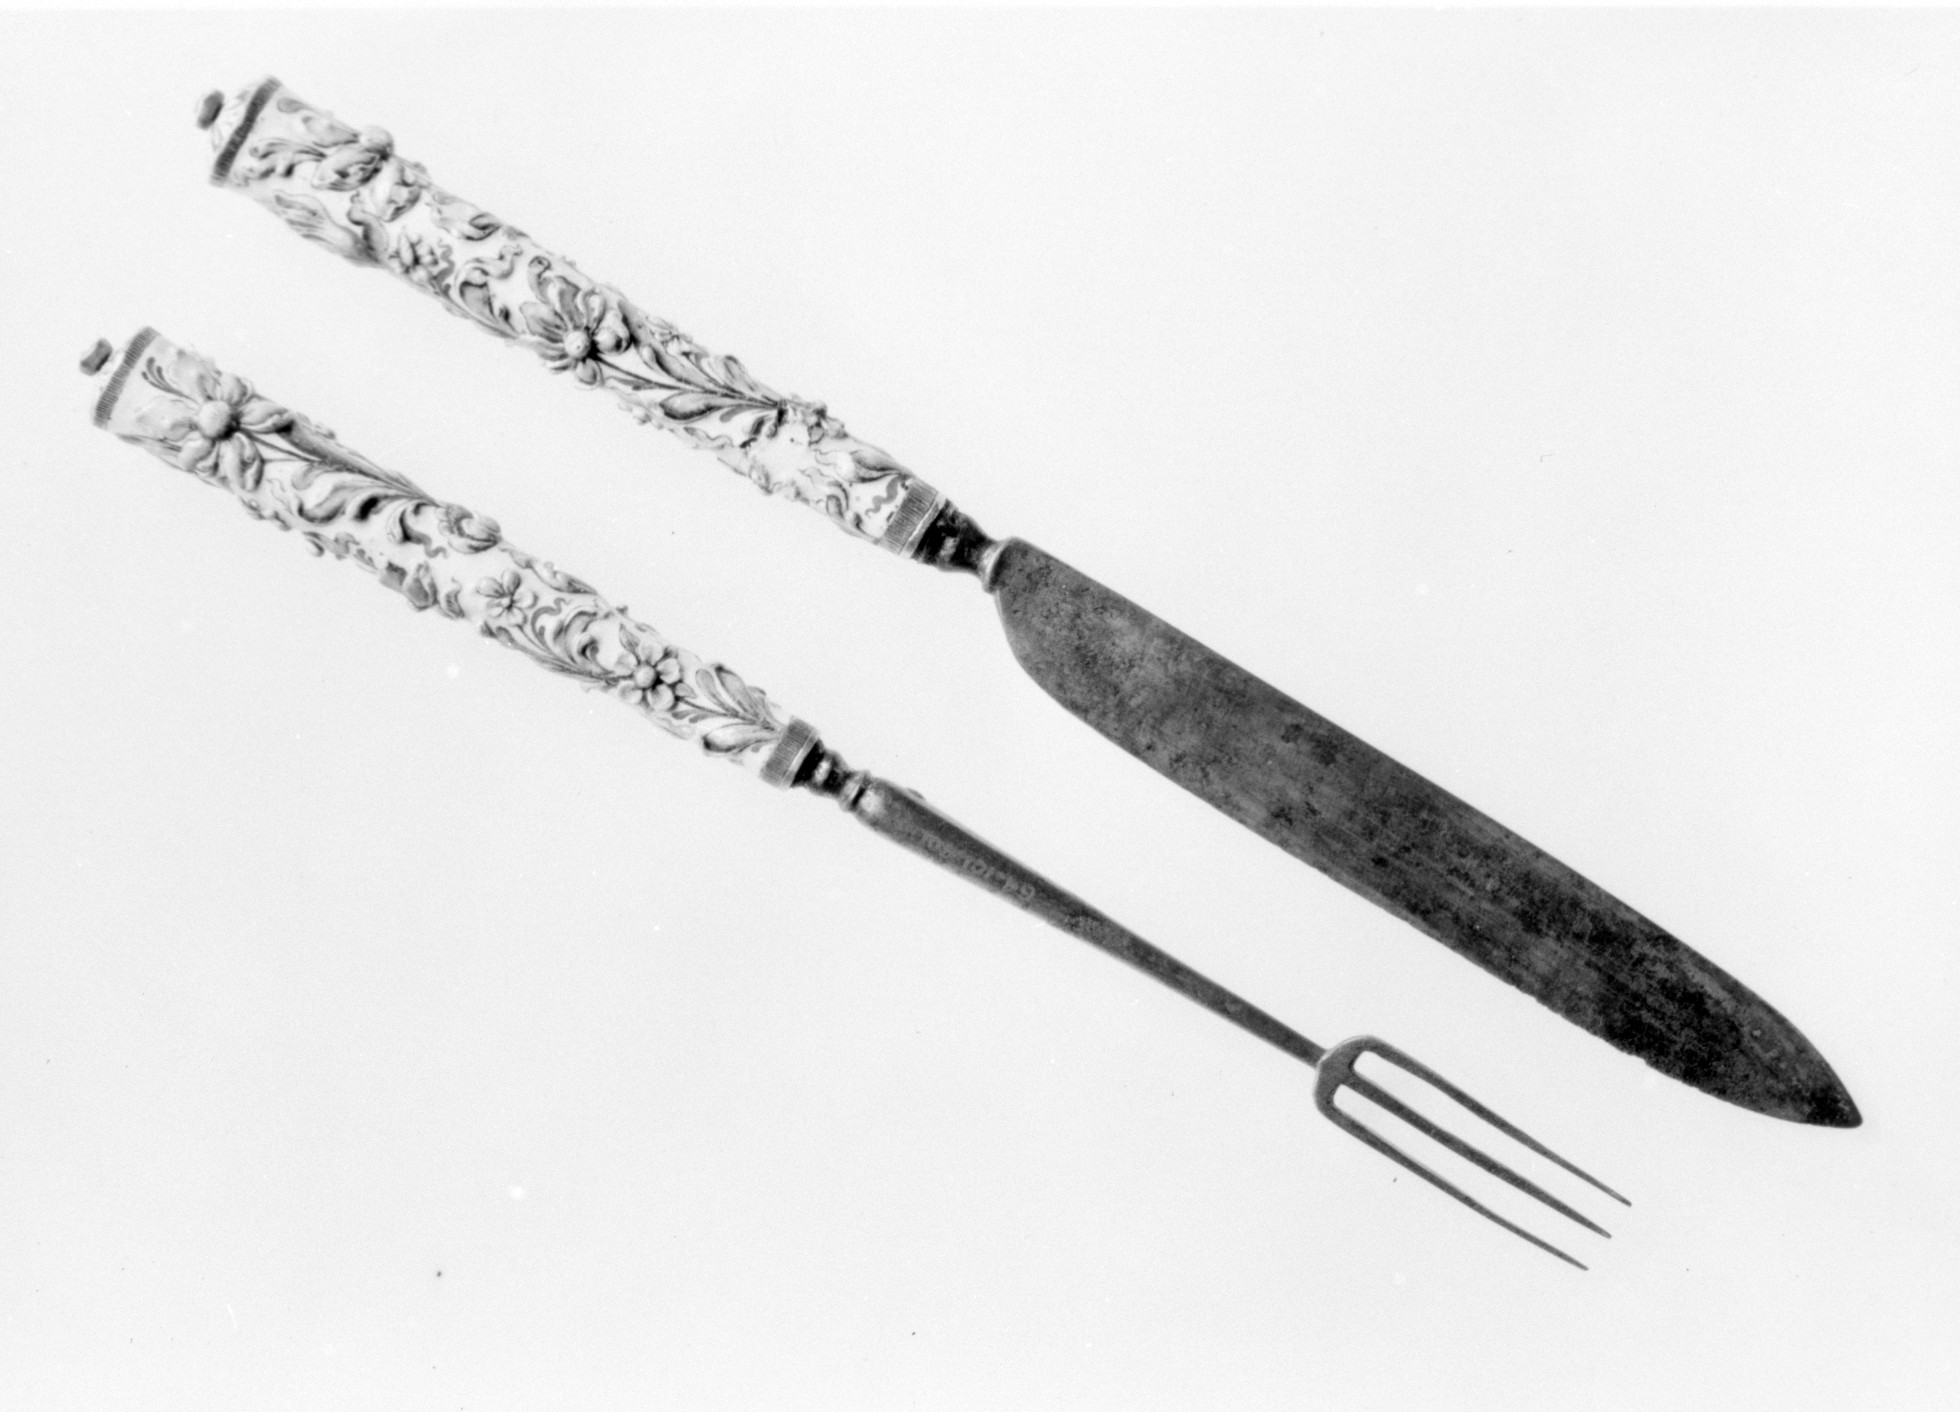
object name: knife and fork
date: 1651-1700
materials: copper, enamel, garnet, steel